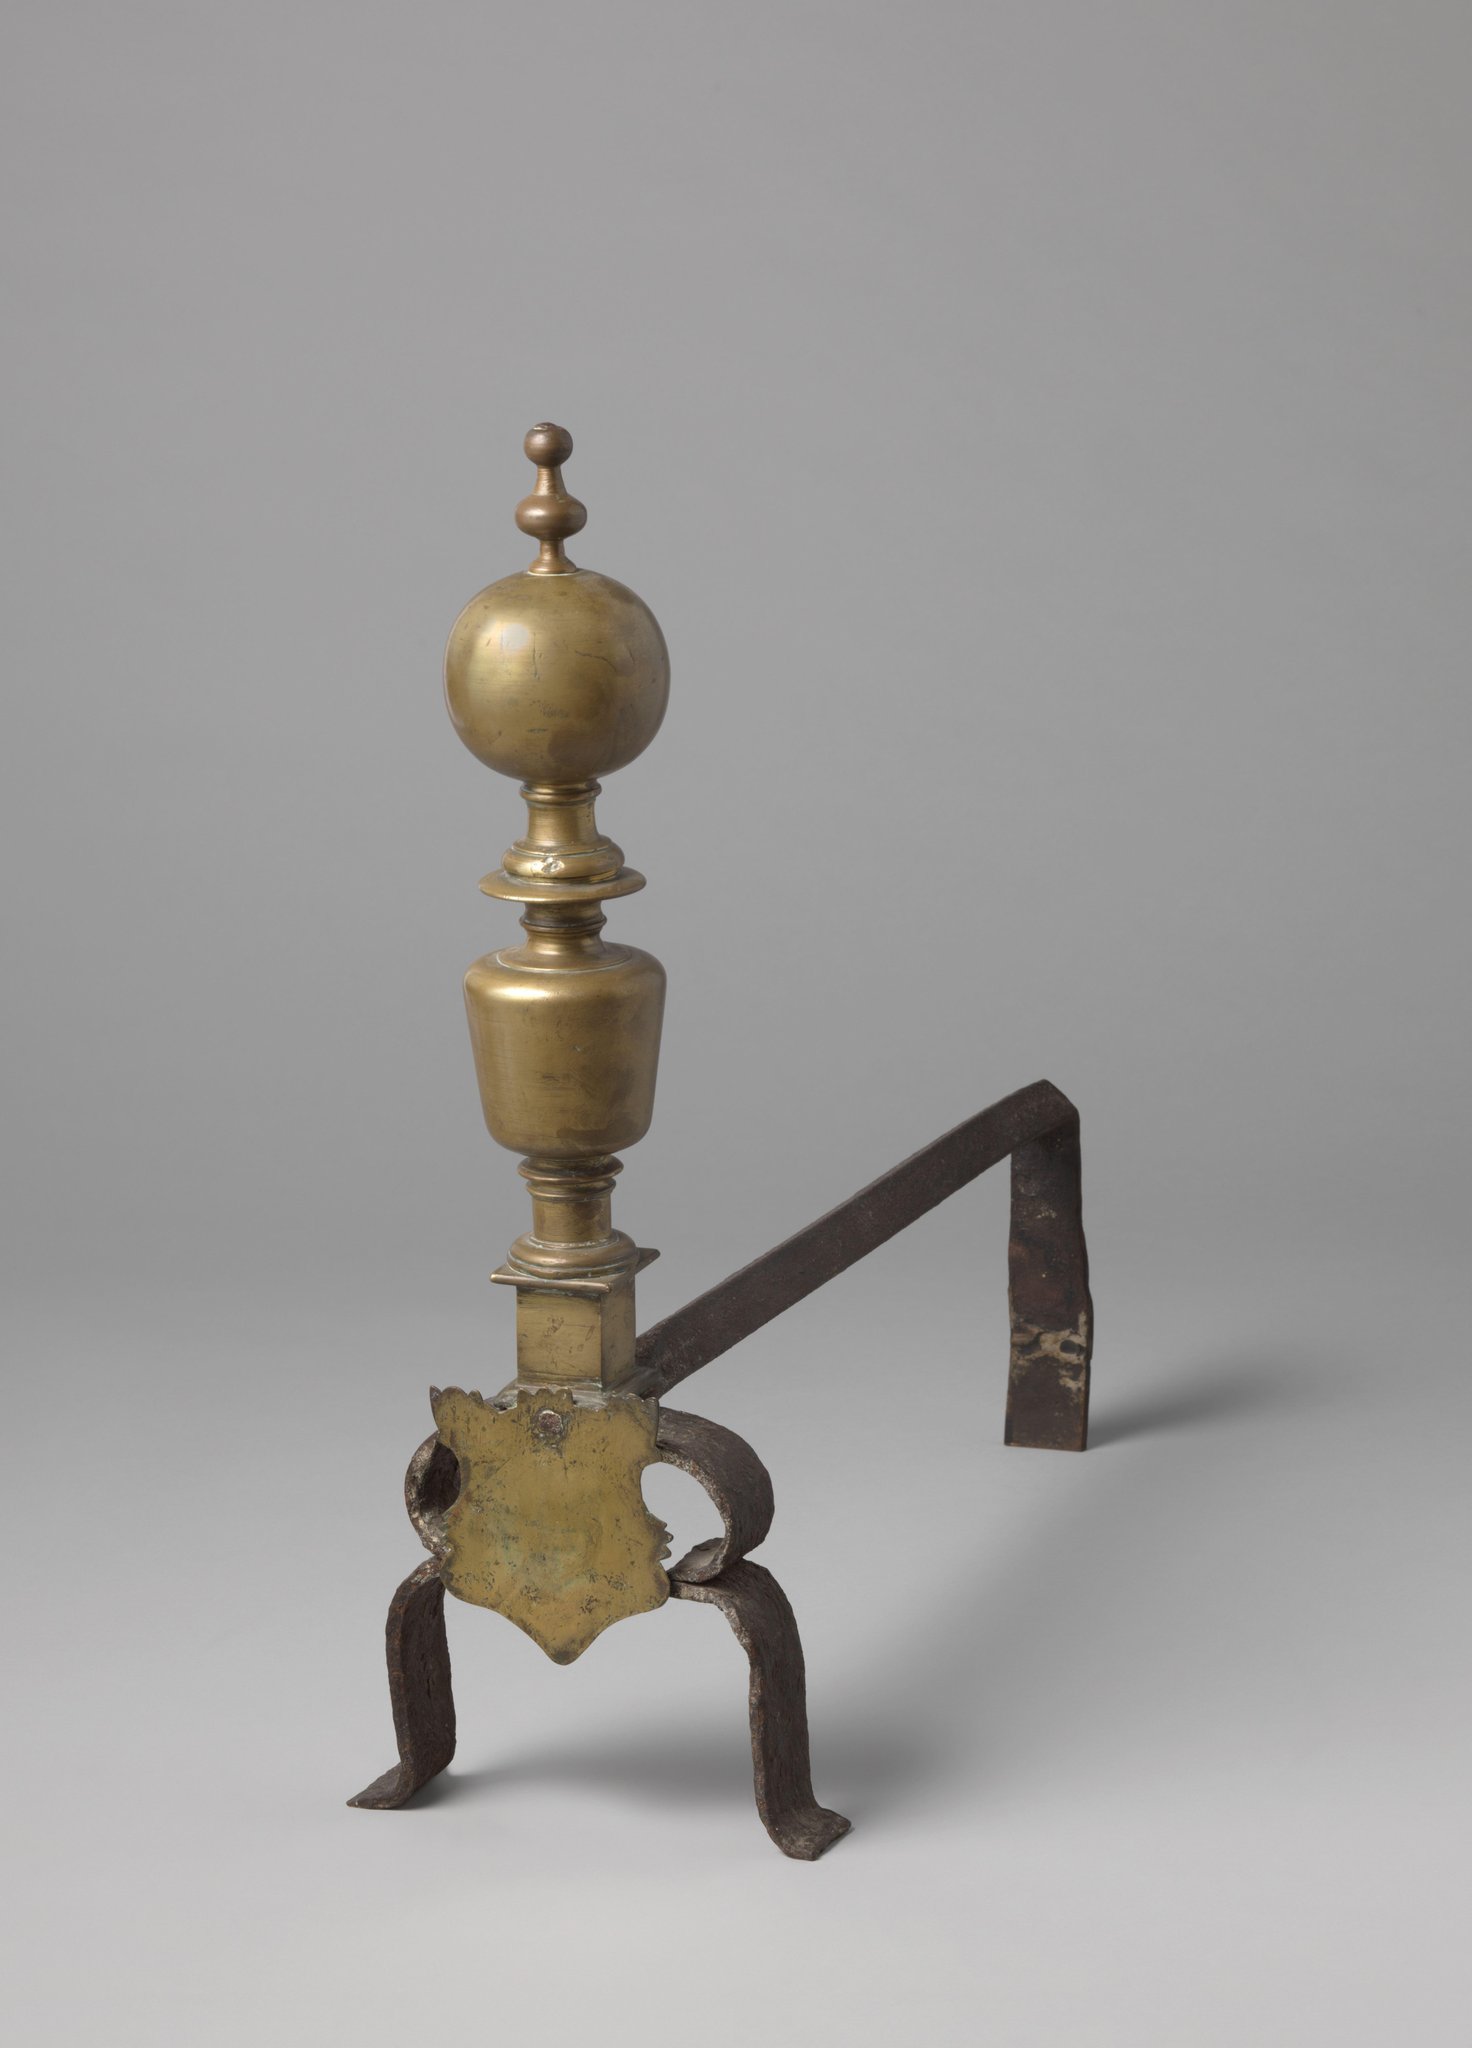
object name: andiron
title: Haardijzer met een versiering bestaande uit een schild, een conische baluster en een bol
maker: Anonymous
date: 1600-1699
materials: brass, iron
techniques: casting, cutting, forging, riveted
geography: spain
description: Het voorwerp bestaat uit drie aaneengeklonken smeedijzeren delen (de stan om het hout op te leggen, de voet, de verticale stang) en uit vijf daarop gemonteerde geelkoperen delen (een uit plaat gesneden schild, de geprofileerde vierkante voet, de geprofileerde gedeeltelijk conisch gevormde baluster, de op een geprofileerde voet geplaatste bol, de vaasvormige knop). De ijzeren verticale stang is op de knop vastgeklonken.